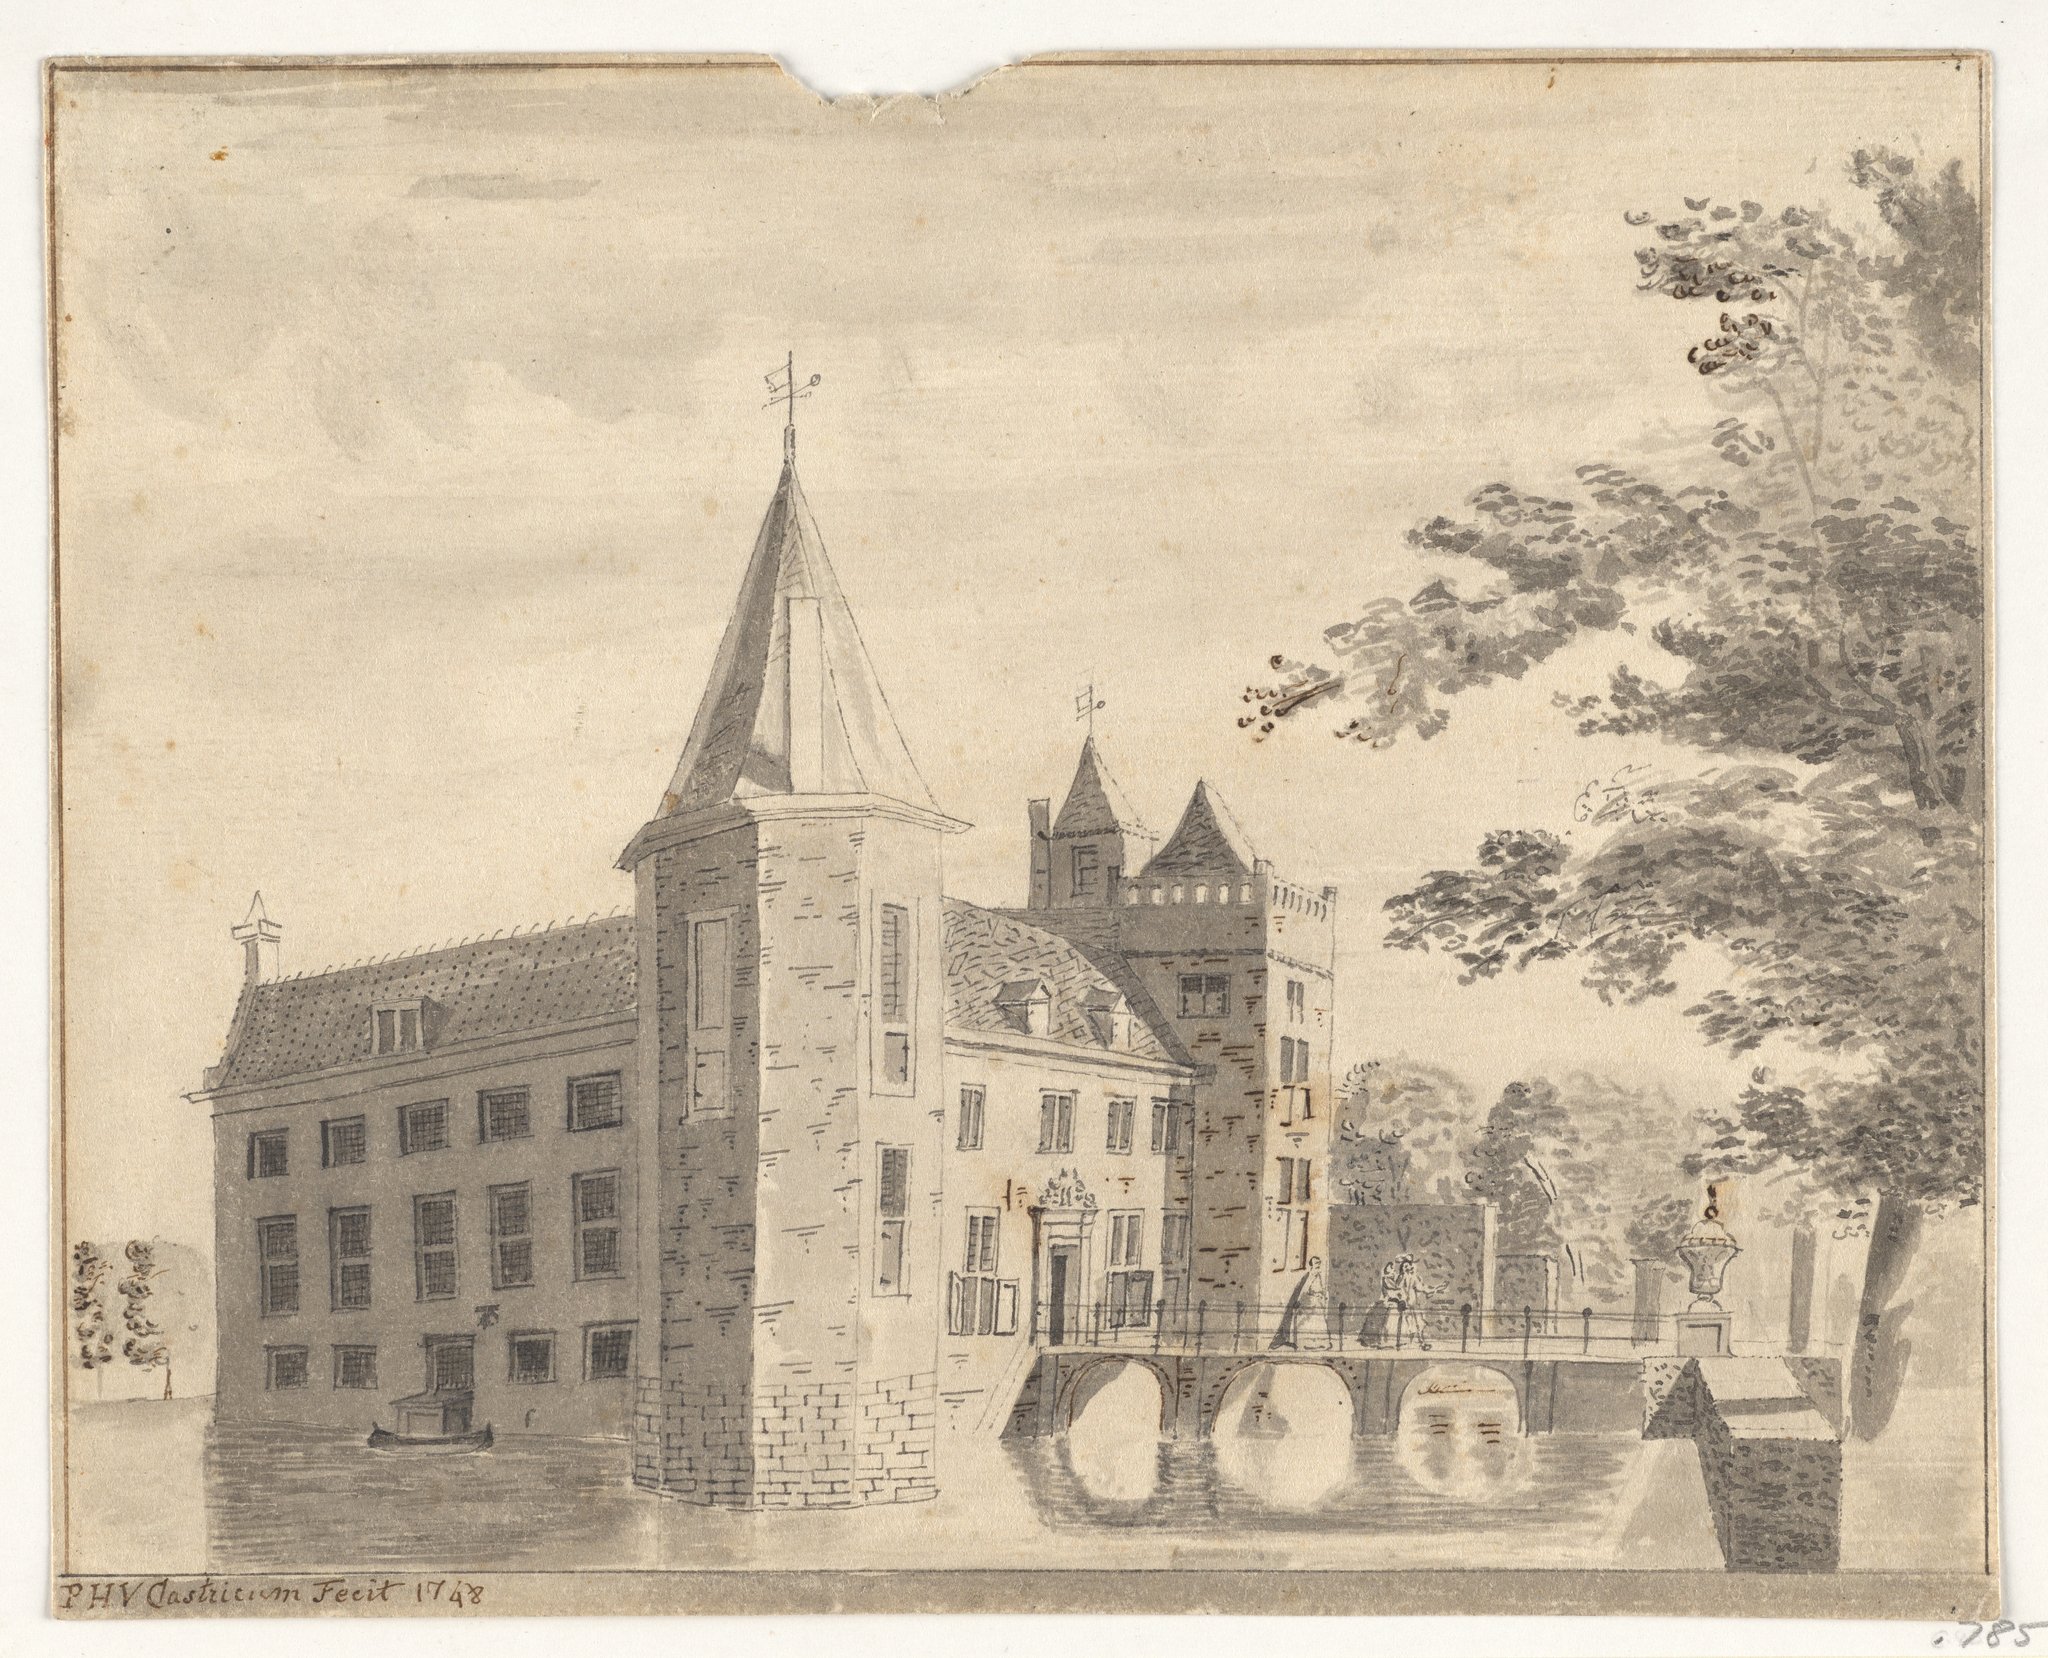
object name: drawing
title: View of a Castle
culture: dutch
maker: monogrammist pvh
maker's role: artist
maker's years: 1748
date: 1748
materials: ink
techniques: brush, pen, wash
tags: castles,bridges